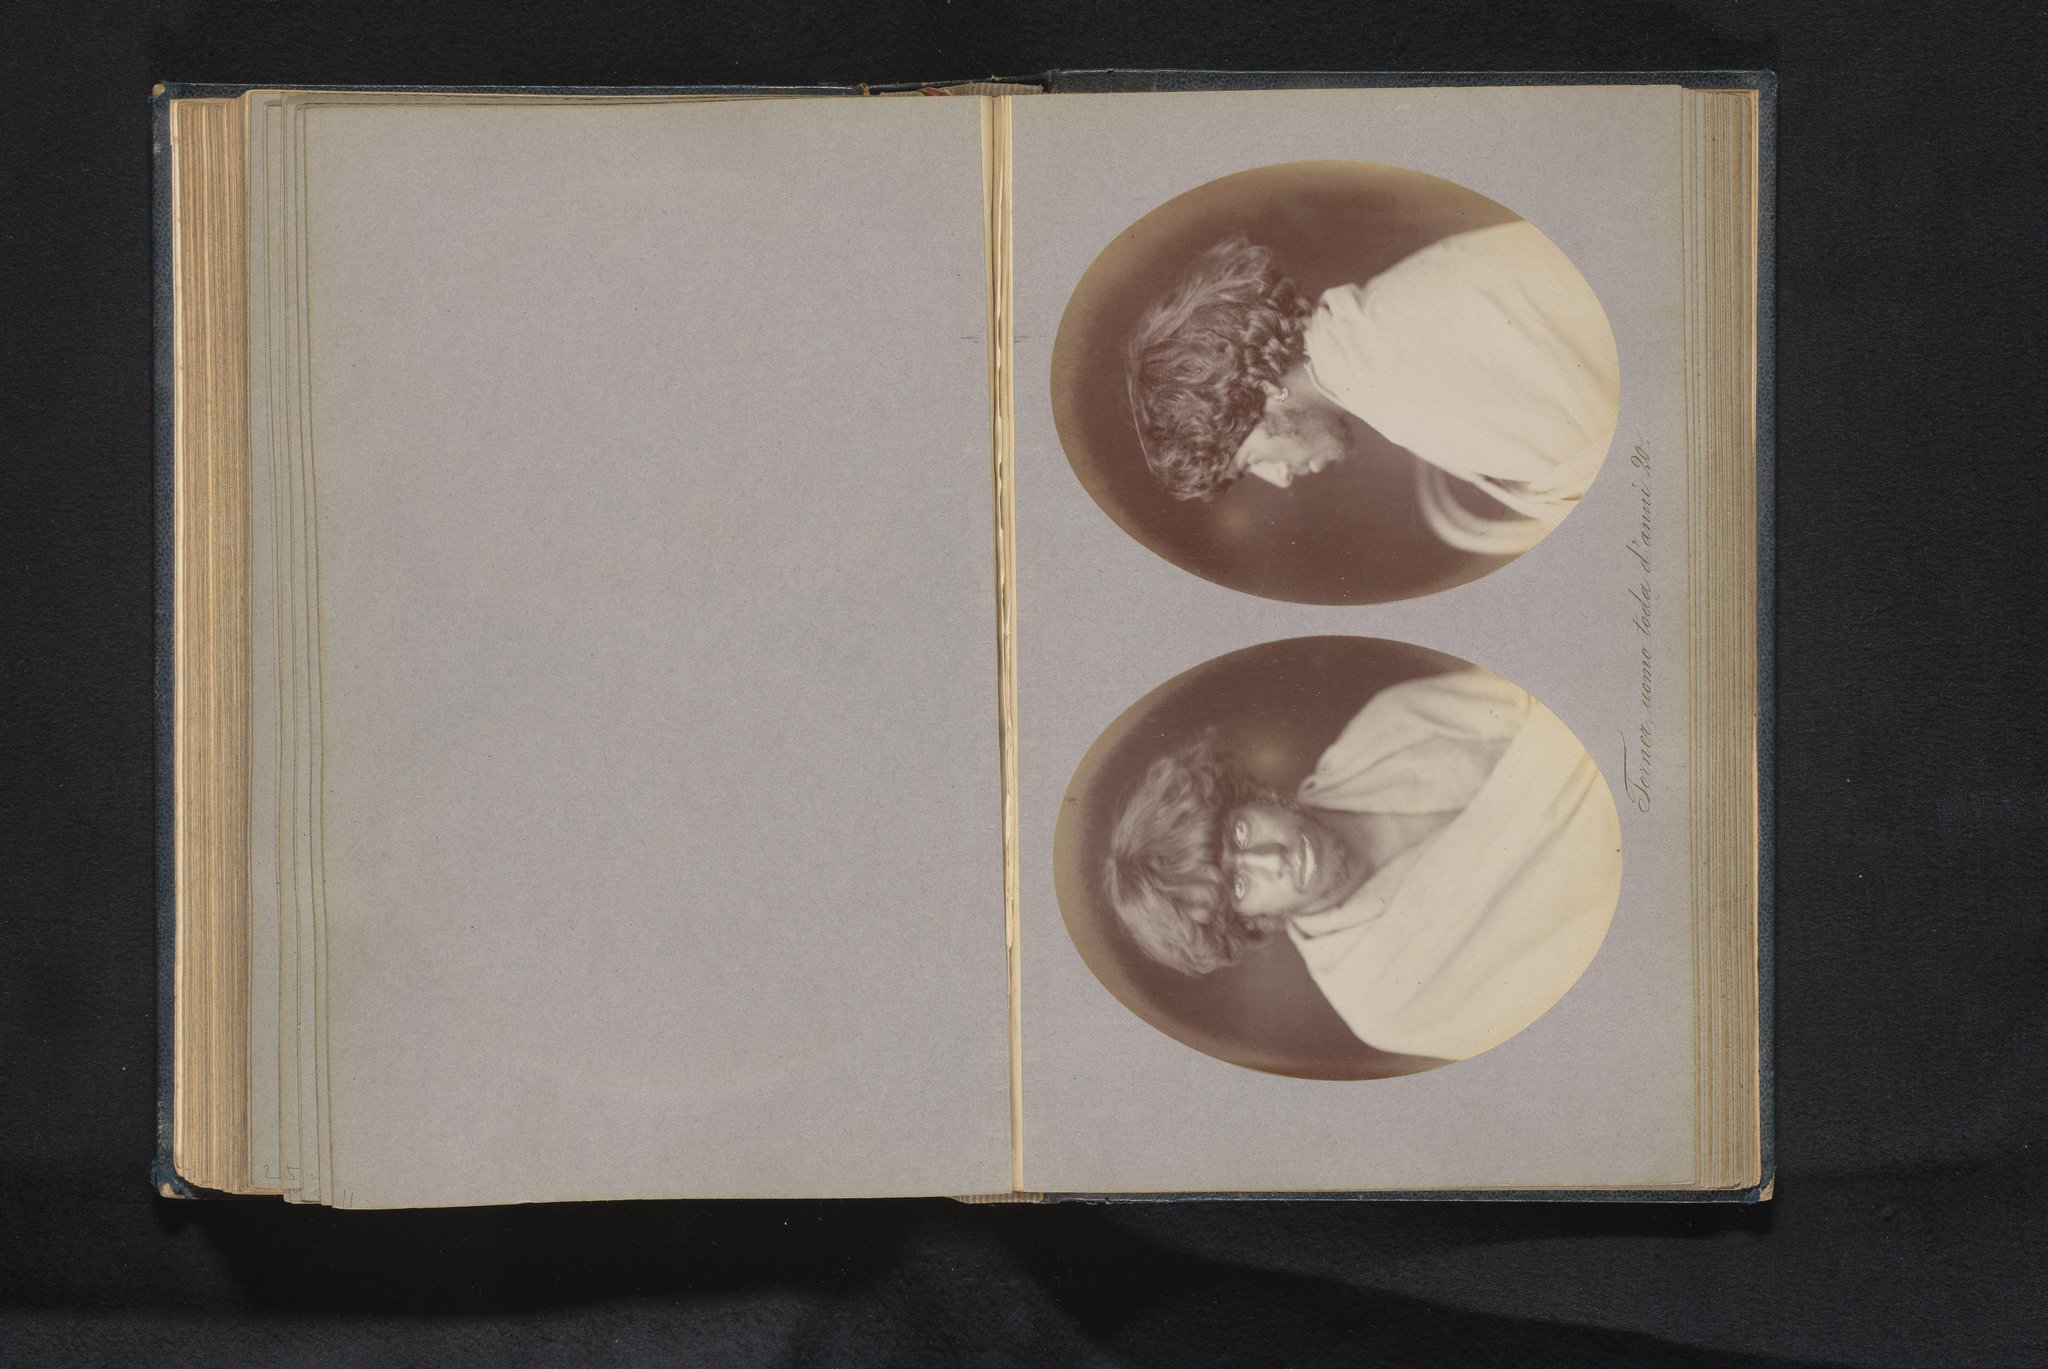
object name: photograph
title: Twee portretten van Torner van de Toda-stam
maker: paolo mantegazza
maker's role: antropoloog, professor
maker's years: 1831-1910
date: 1881-1886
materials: photographic support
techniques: albumen print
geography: india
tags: adult man (+ front view), adult man (+ sideview, profile)